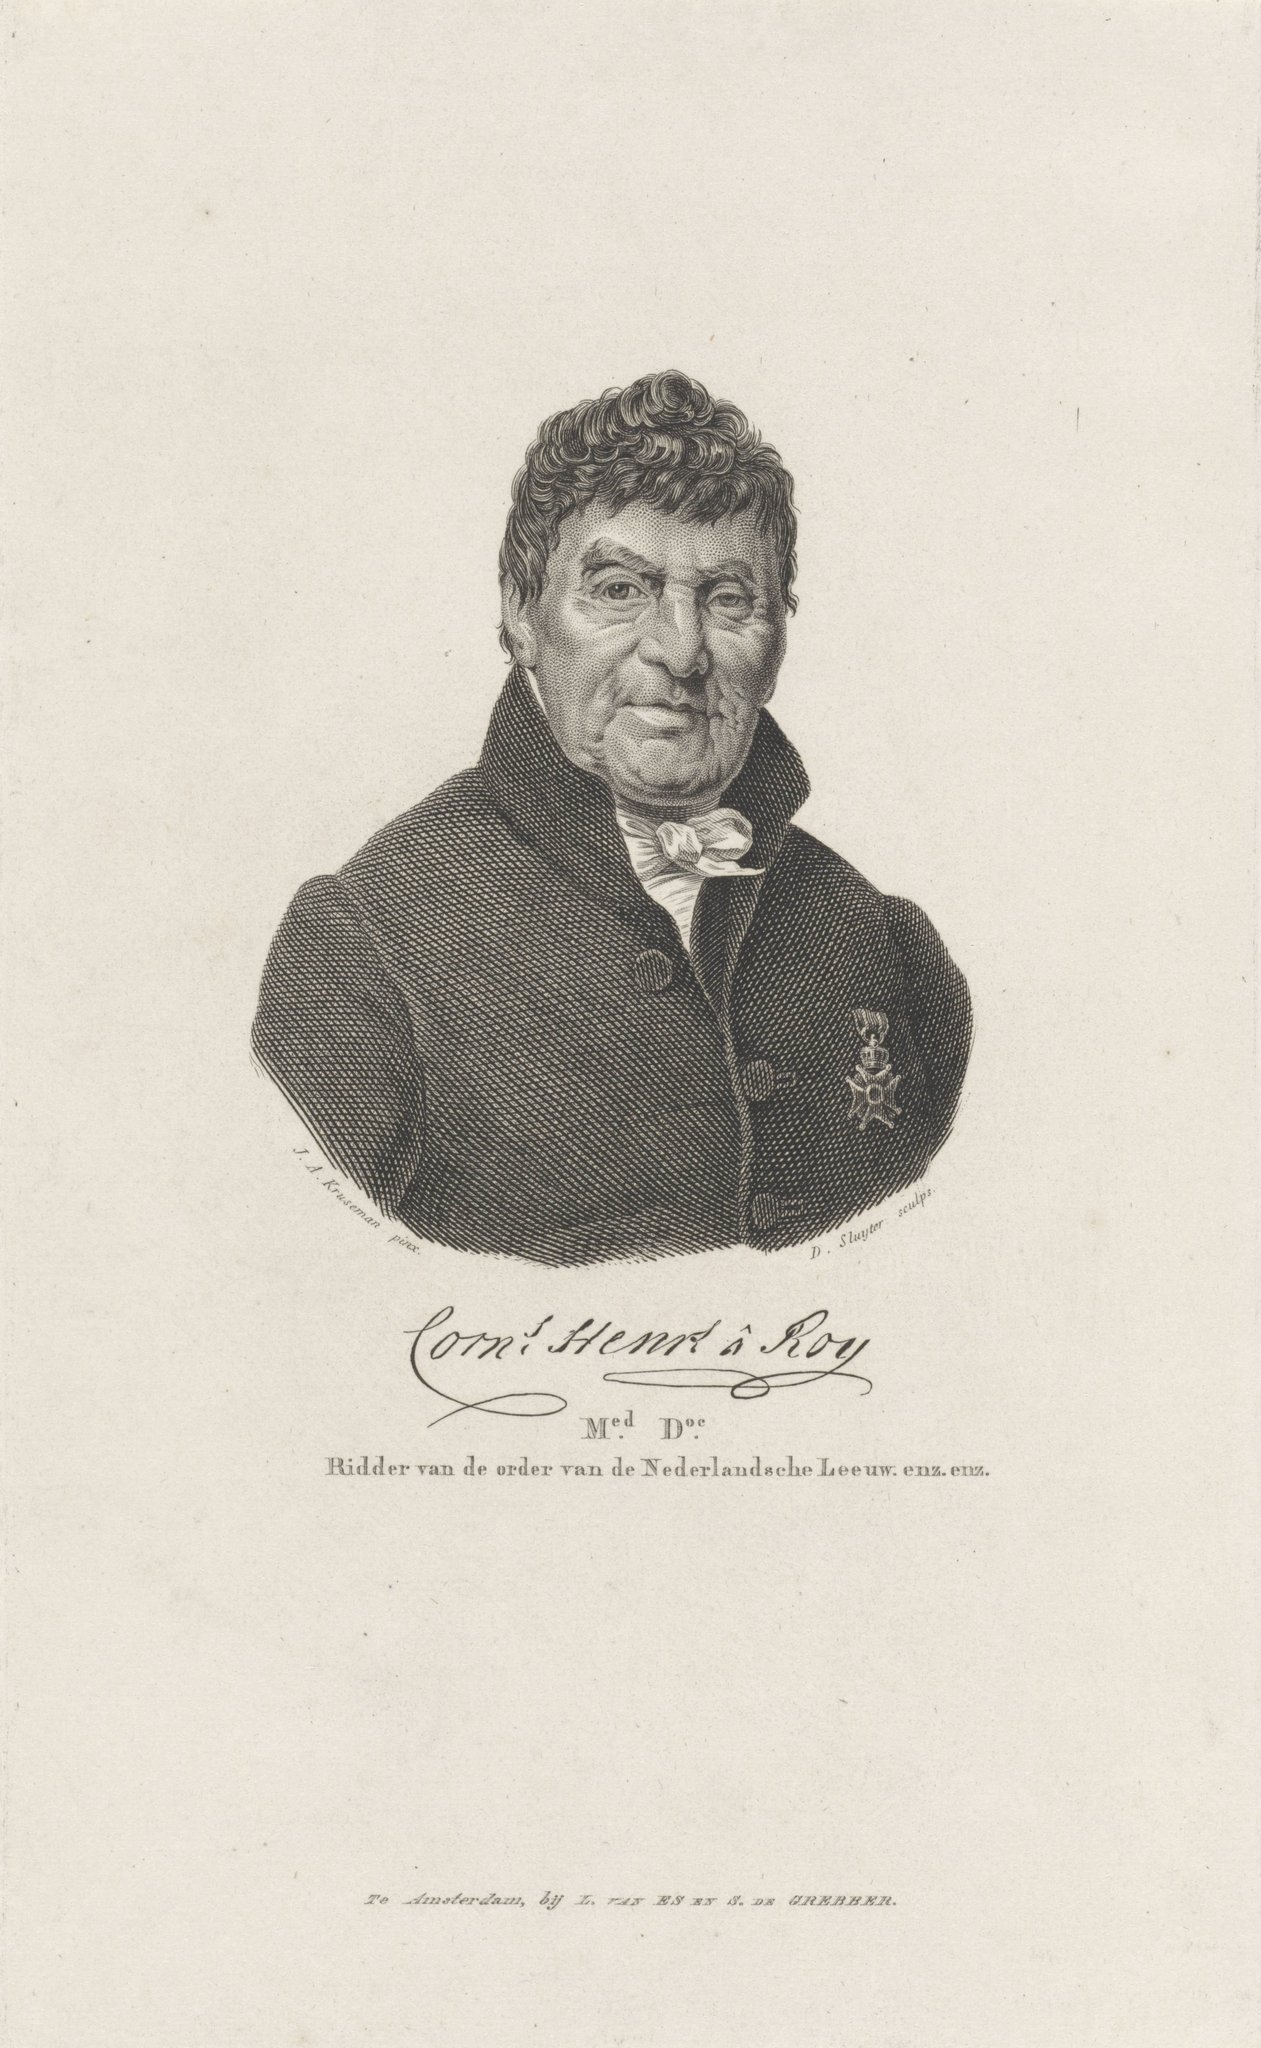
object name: print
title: Portret van Cornelius Henricus à Roy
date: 1810-1835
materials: paper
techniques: engraving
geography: amsterdam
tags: arts, cornelius henricus à roy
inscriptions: collector's mark: Lugt 2228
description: Portret van Cornelius Henricus à Roy, lijfarts van koning Lodewijk Napoleon Bonaparte. Op zijn borst draagt hij het teken van de Orde van de Nederlandse Leeuw.